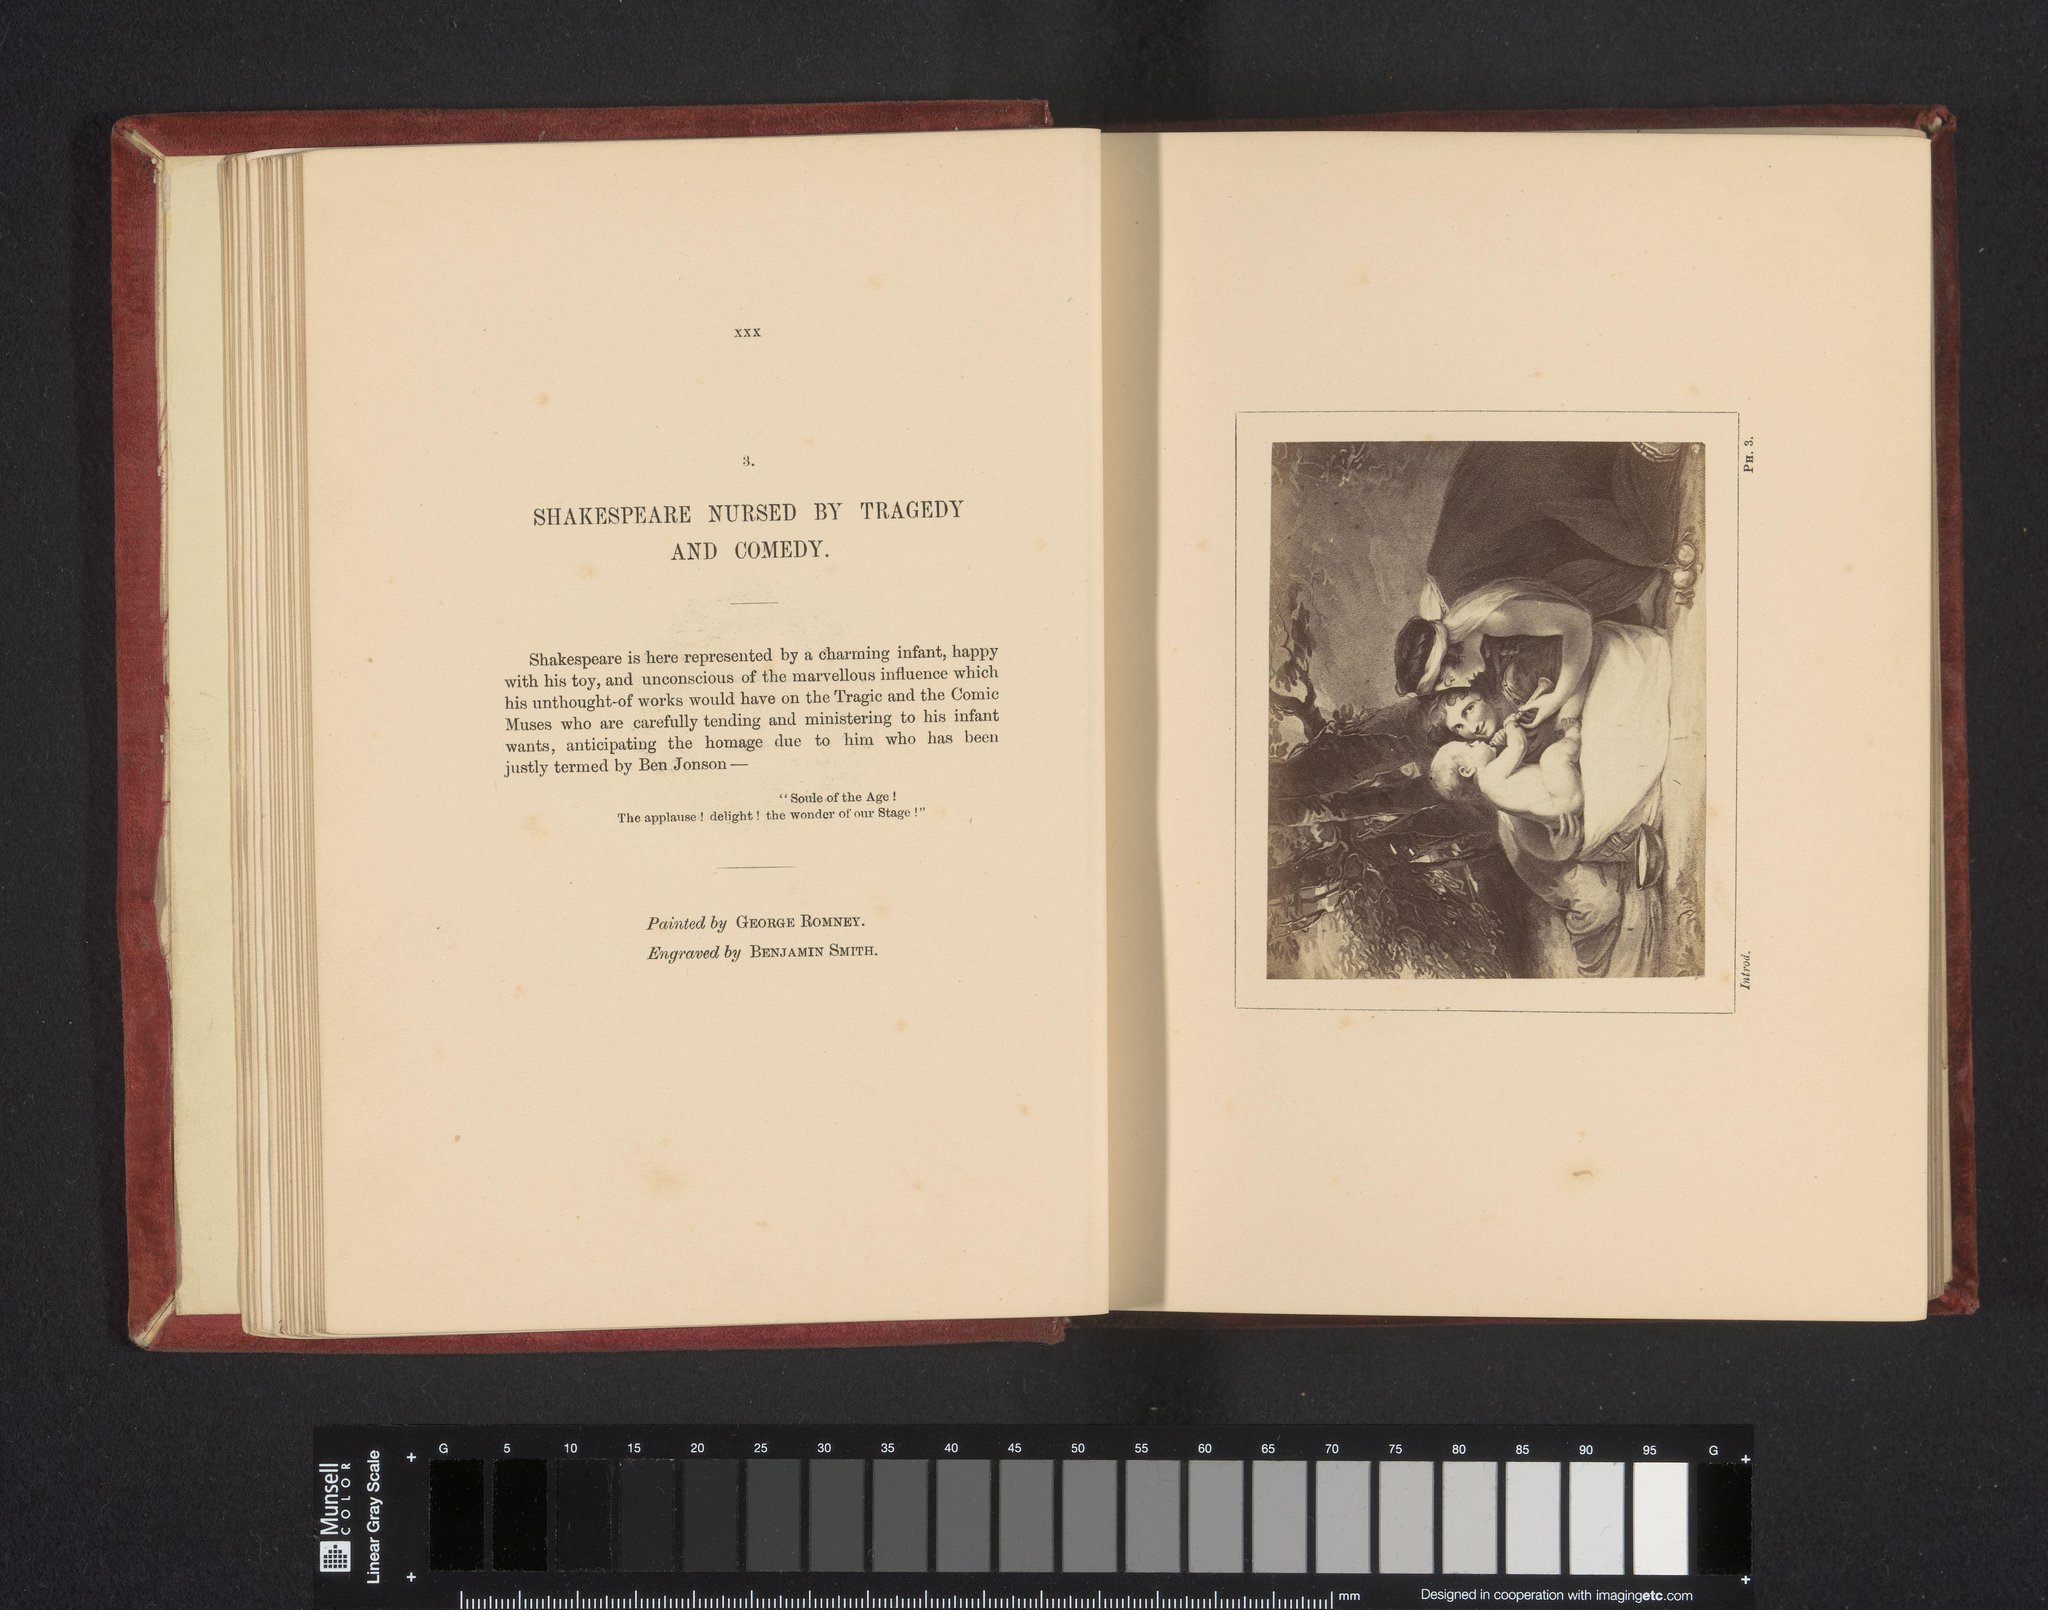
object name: page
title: Fotoreproductie van een prent naar een schilderij door George Romney, voorstellend William Shakespeare als baby die verzorgd wordt door vrouwelijke personificaties van tragedie en komedie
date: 1854-1864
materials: photographic support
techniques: albumen print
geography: london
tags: william shakespeare, 'comedia', 'comedia vecchia' (ripa), infant, baby, 'tragedia' (ripa)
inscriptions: number: ‘Introd. Ph. 3.’